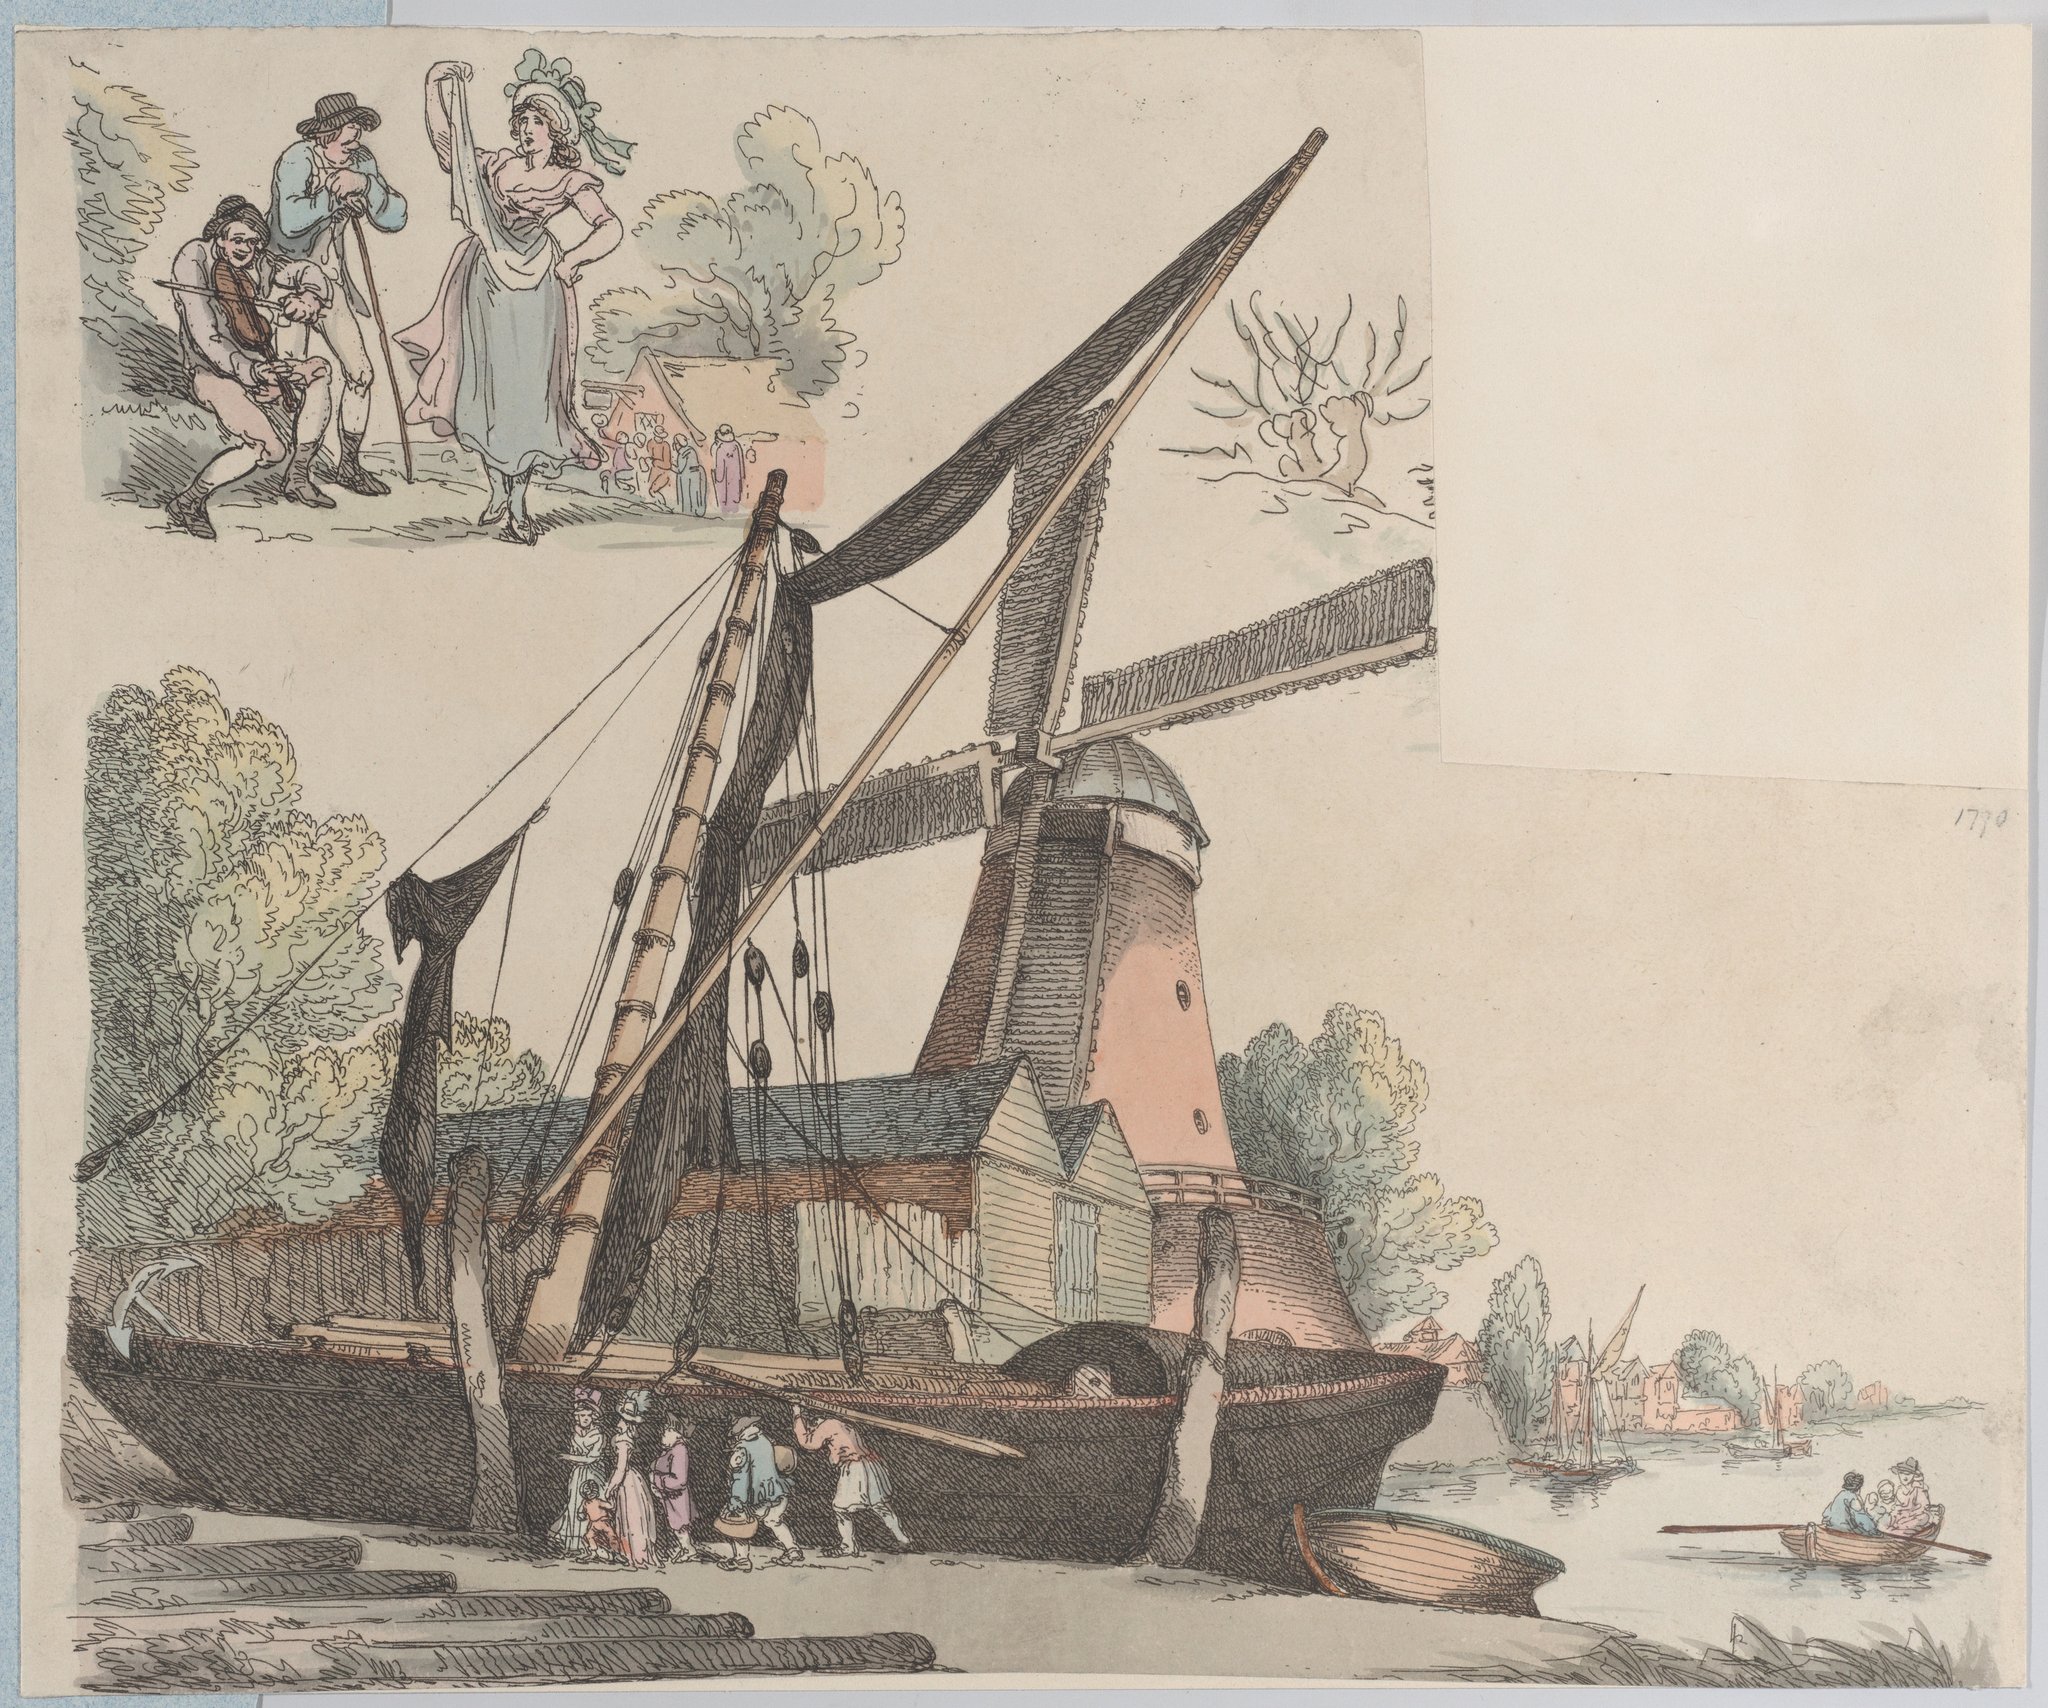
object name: print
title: River Scene with Windmill (from Plate 9, Outlines of Figures, Landscapes and Cattle...for the Use of Learners)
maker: thomas rowlandson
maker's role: artist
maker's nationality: british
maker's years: 1757-1827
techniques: etching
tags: windmills,men,women,boats,carriages